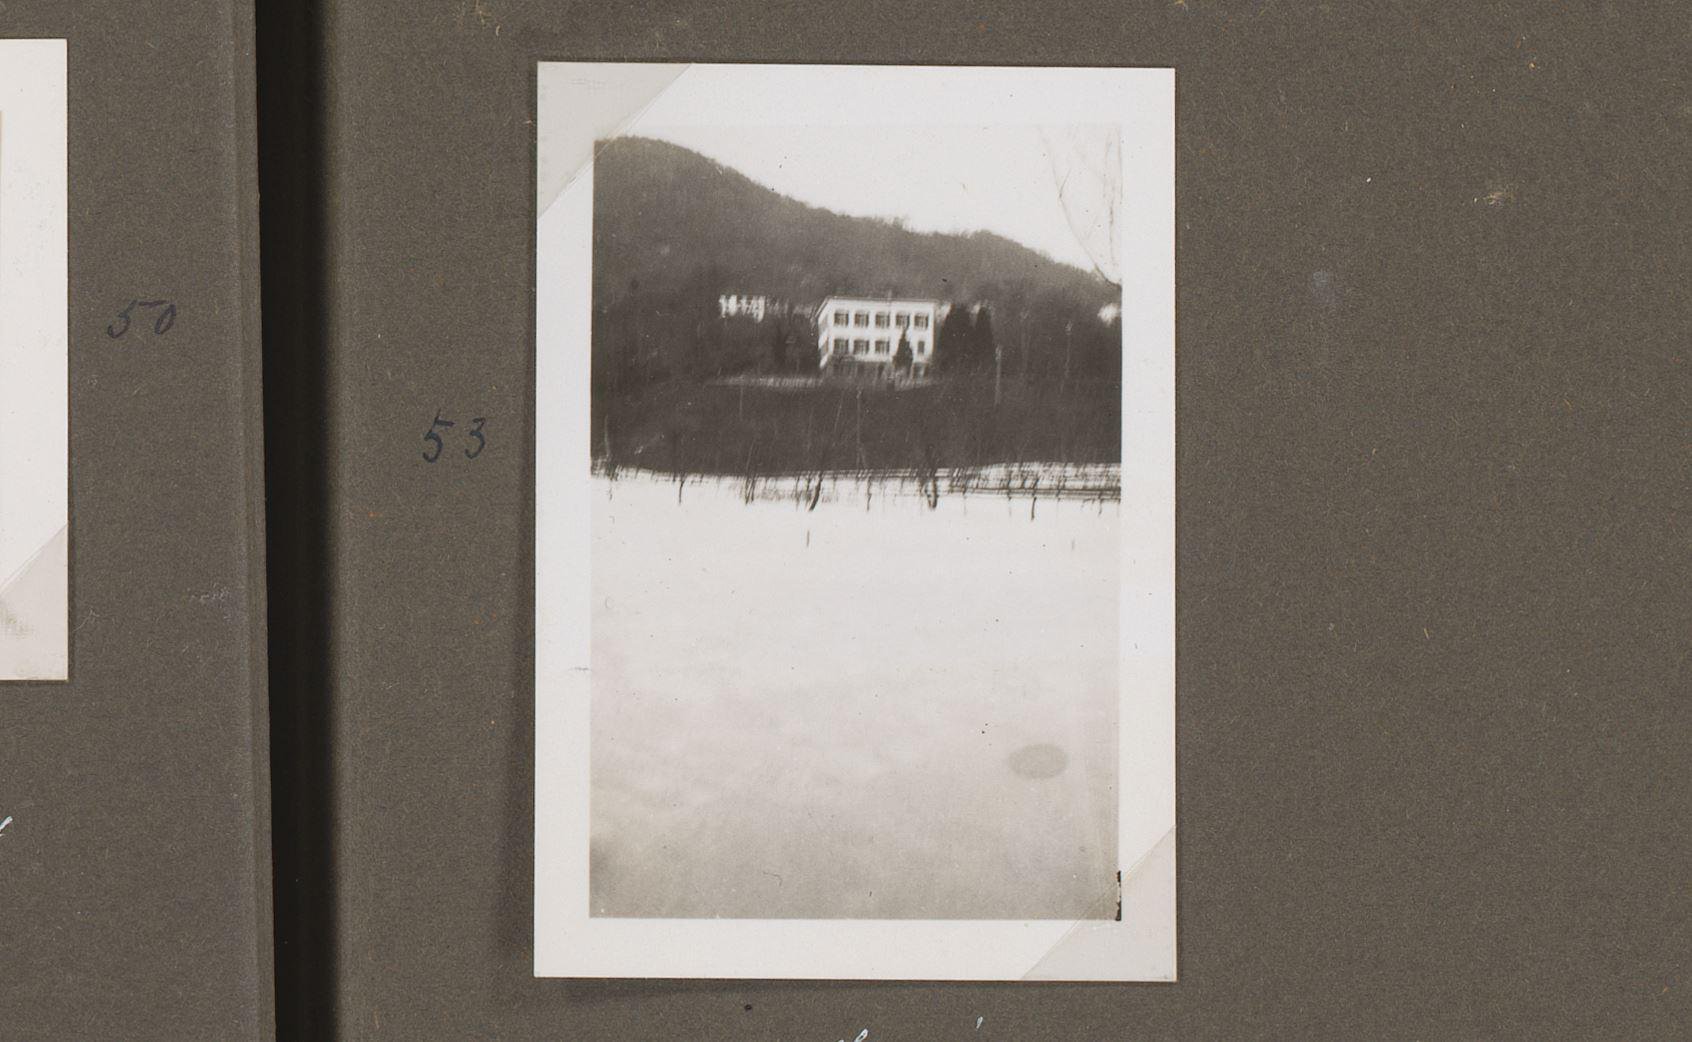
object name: photograph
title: Naar Gola di Lago. Een moeilijk pad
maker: Anonymous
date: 1934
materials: photographic support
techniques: gelatin silver print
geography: capriasca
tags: walking, hiking (recreation), historical persons - bb - woman, mountains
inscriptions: number: ‘52’